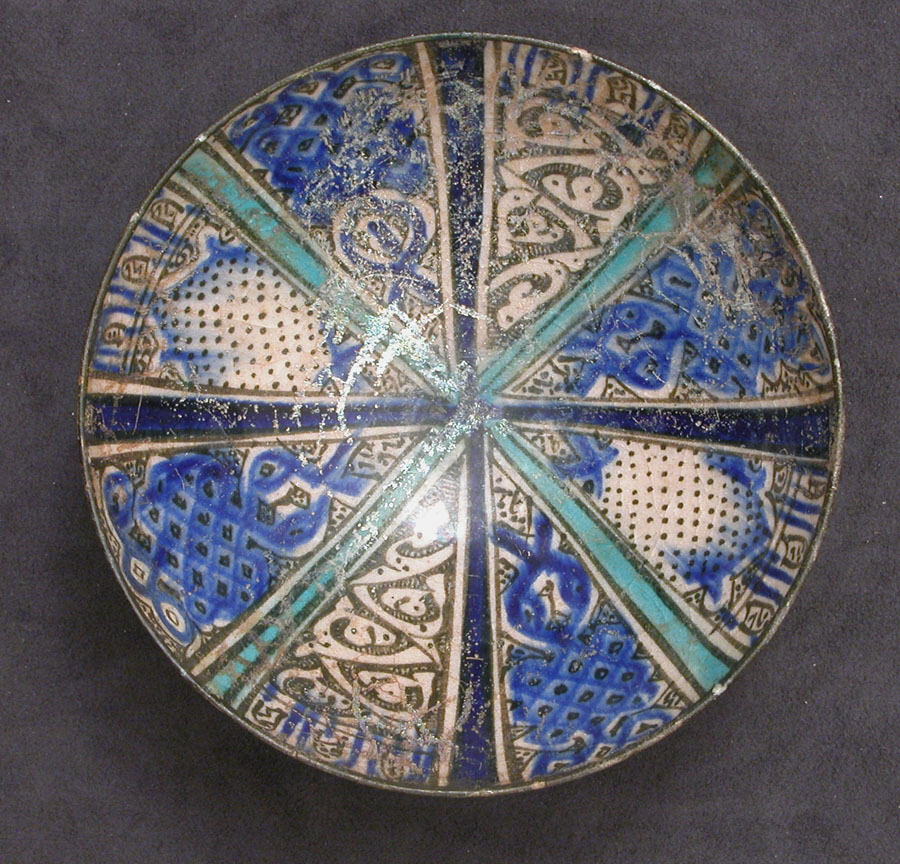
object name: bowl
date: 1301-1350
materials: earthenware, glaze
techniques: painting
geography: syria